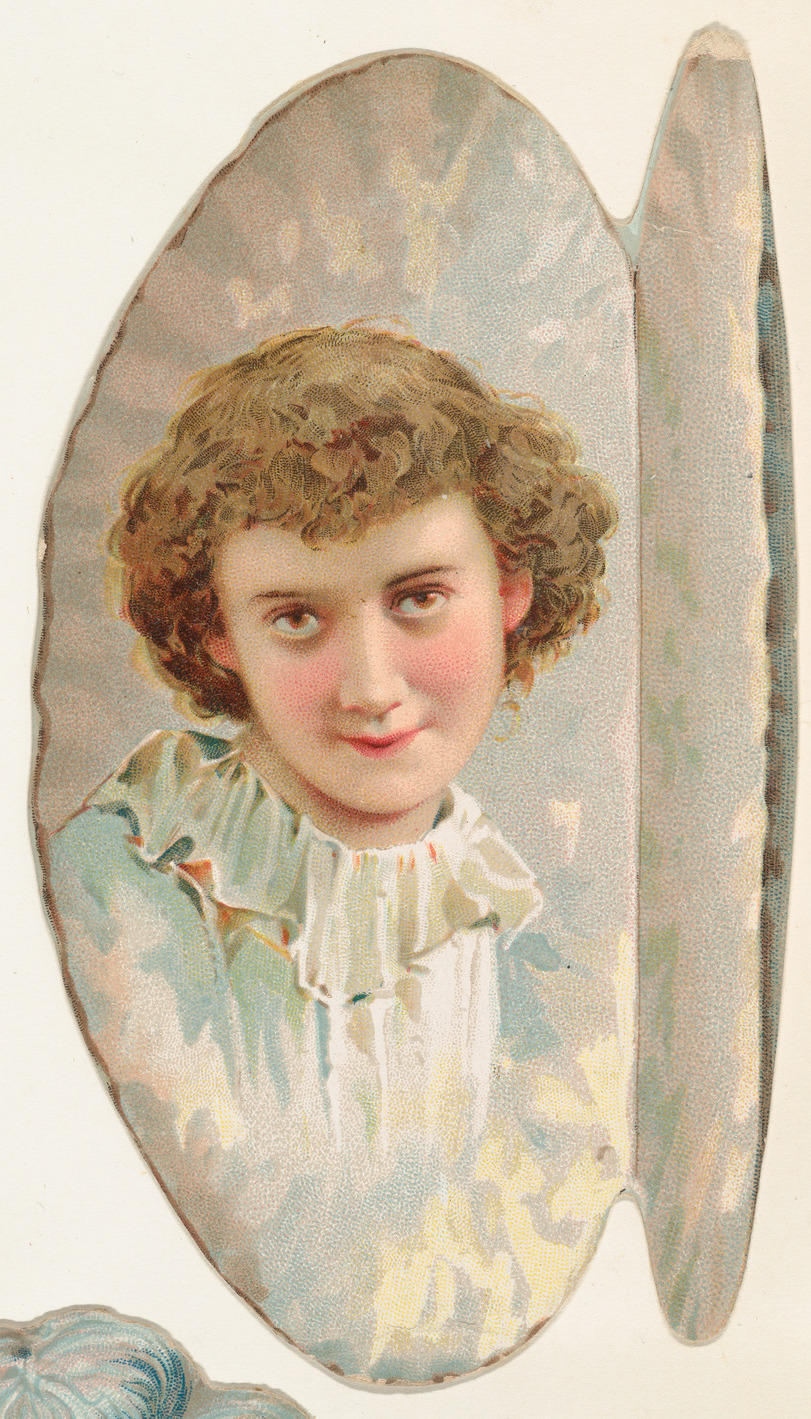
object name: print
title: Seashell, from the Novelties series (N122) issued by Gail & Ax Tobacco to promote Navy Long Cut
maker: gail & ax tobacco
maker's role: publisher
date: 1889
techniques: color lithograph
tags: women,shells